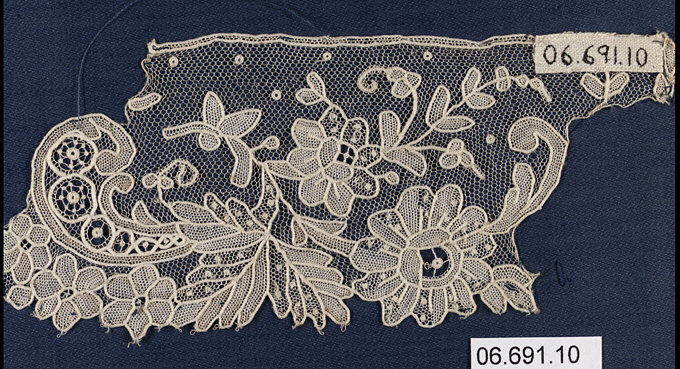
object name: sample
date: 1801-1900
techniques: lace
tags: flowers,leaves